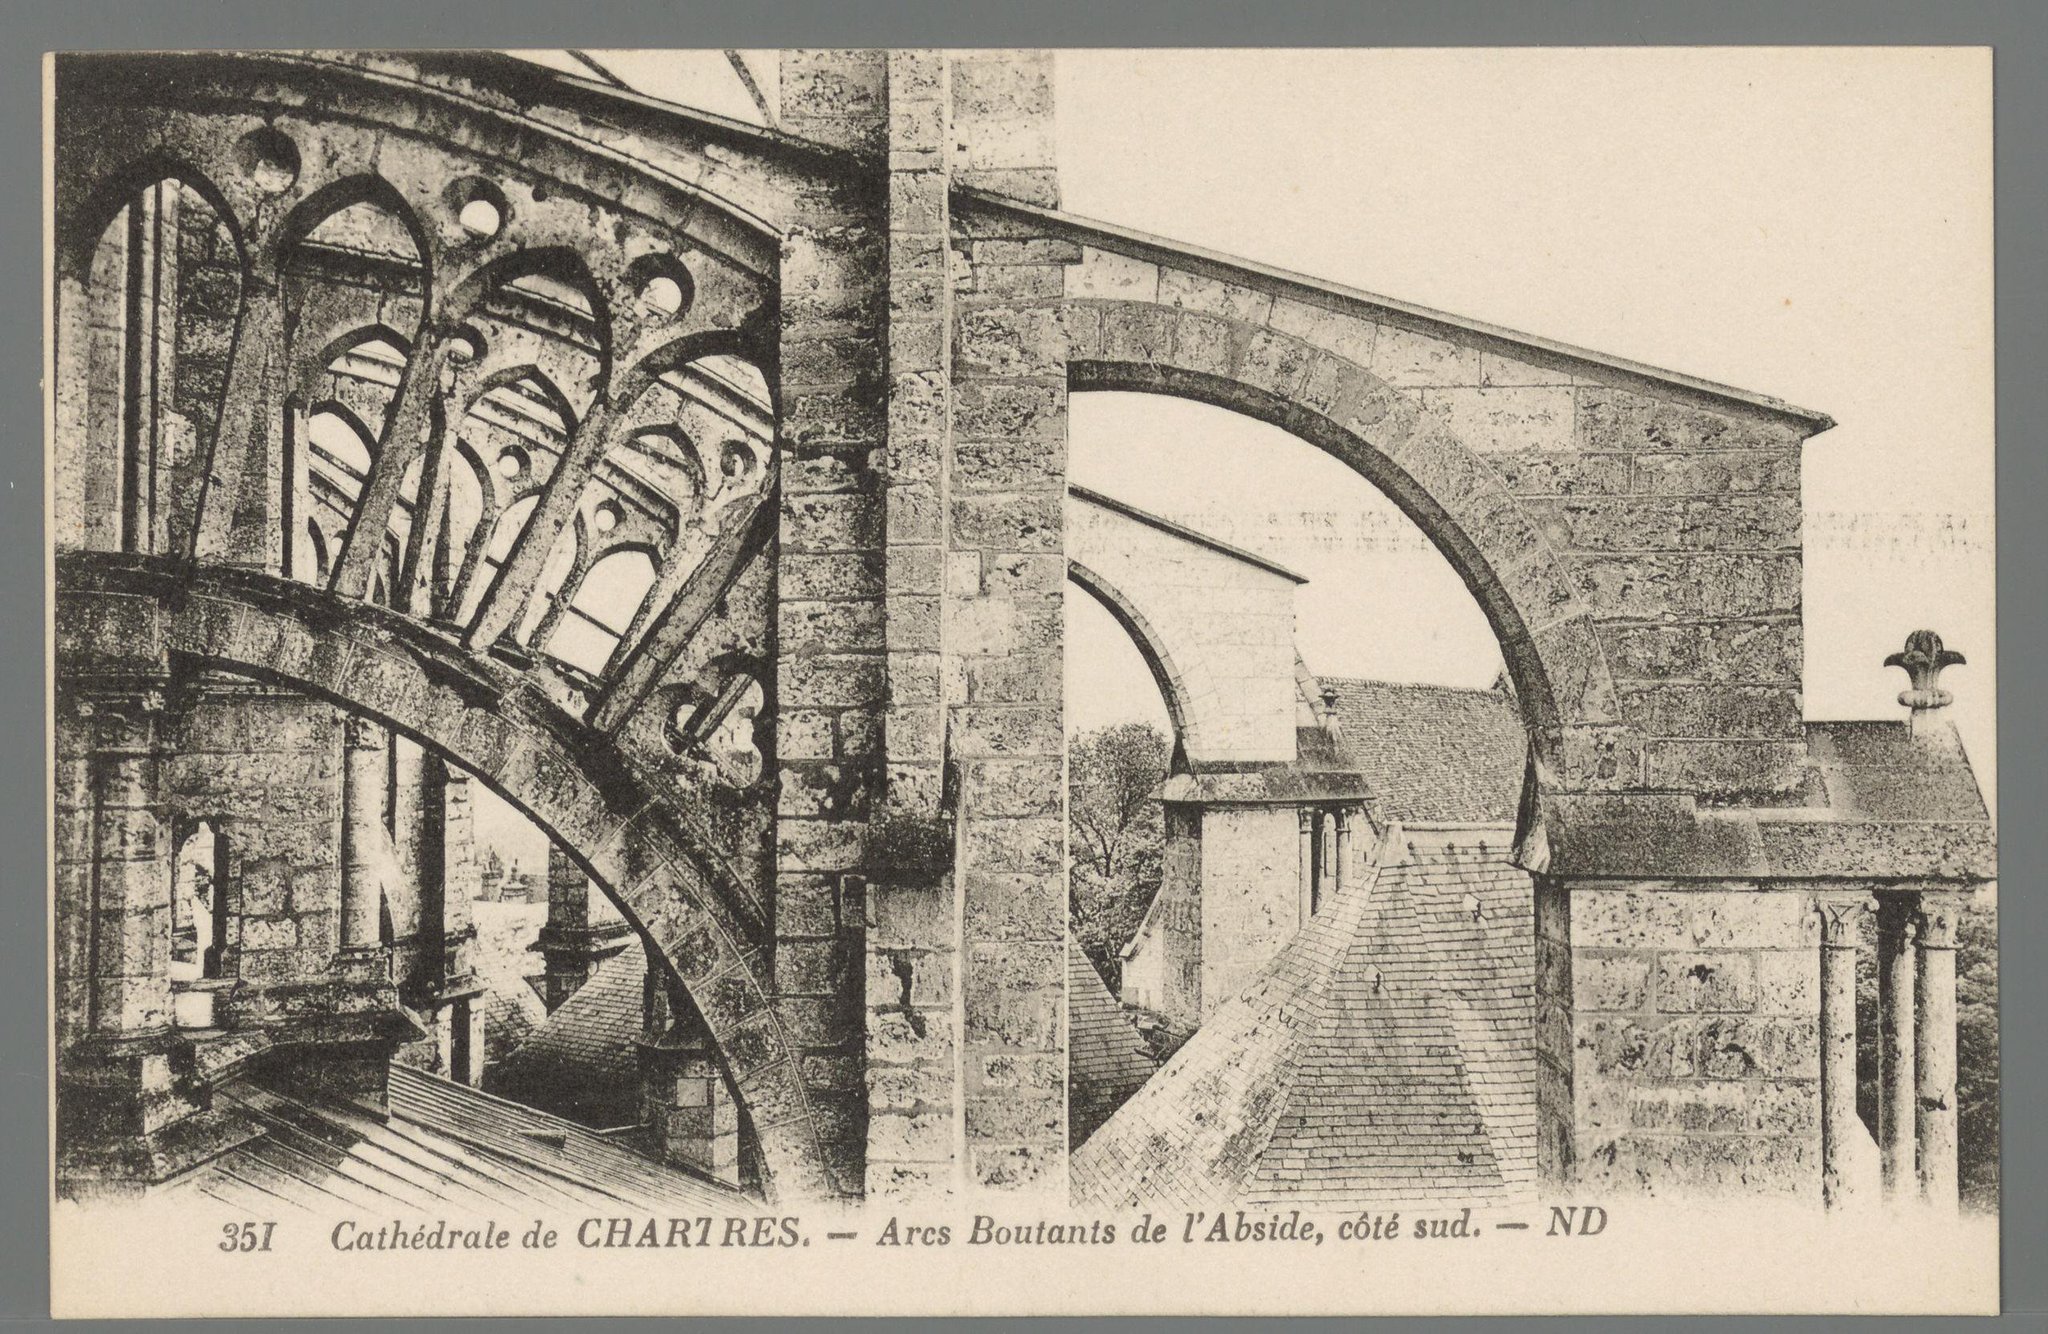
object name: ansichtkaart, prentbriefkaart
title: Cathédrale de Chartres - Arcs Boutants de l'Abside, côté sud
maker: Anonymous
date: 1920-1932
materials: cardboard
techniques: photograph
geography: paris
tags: church (exterior)